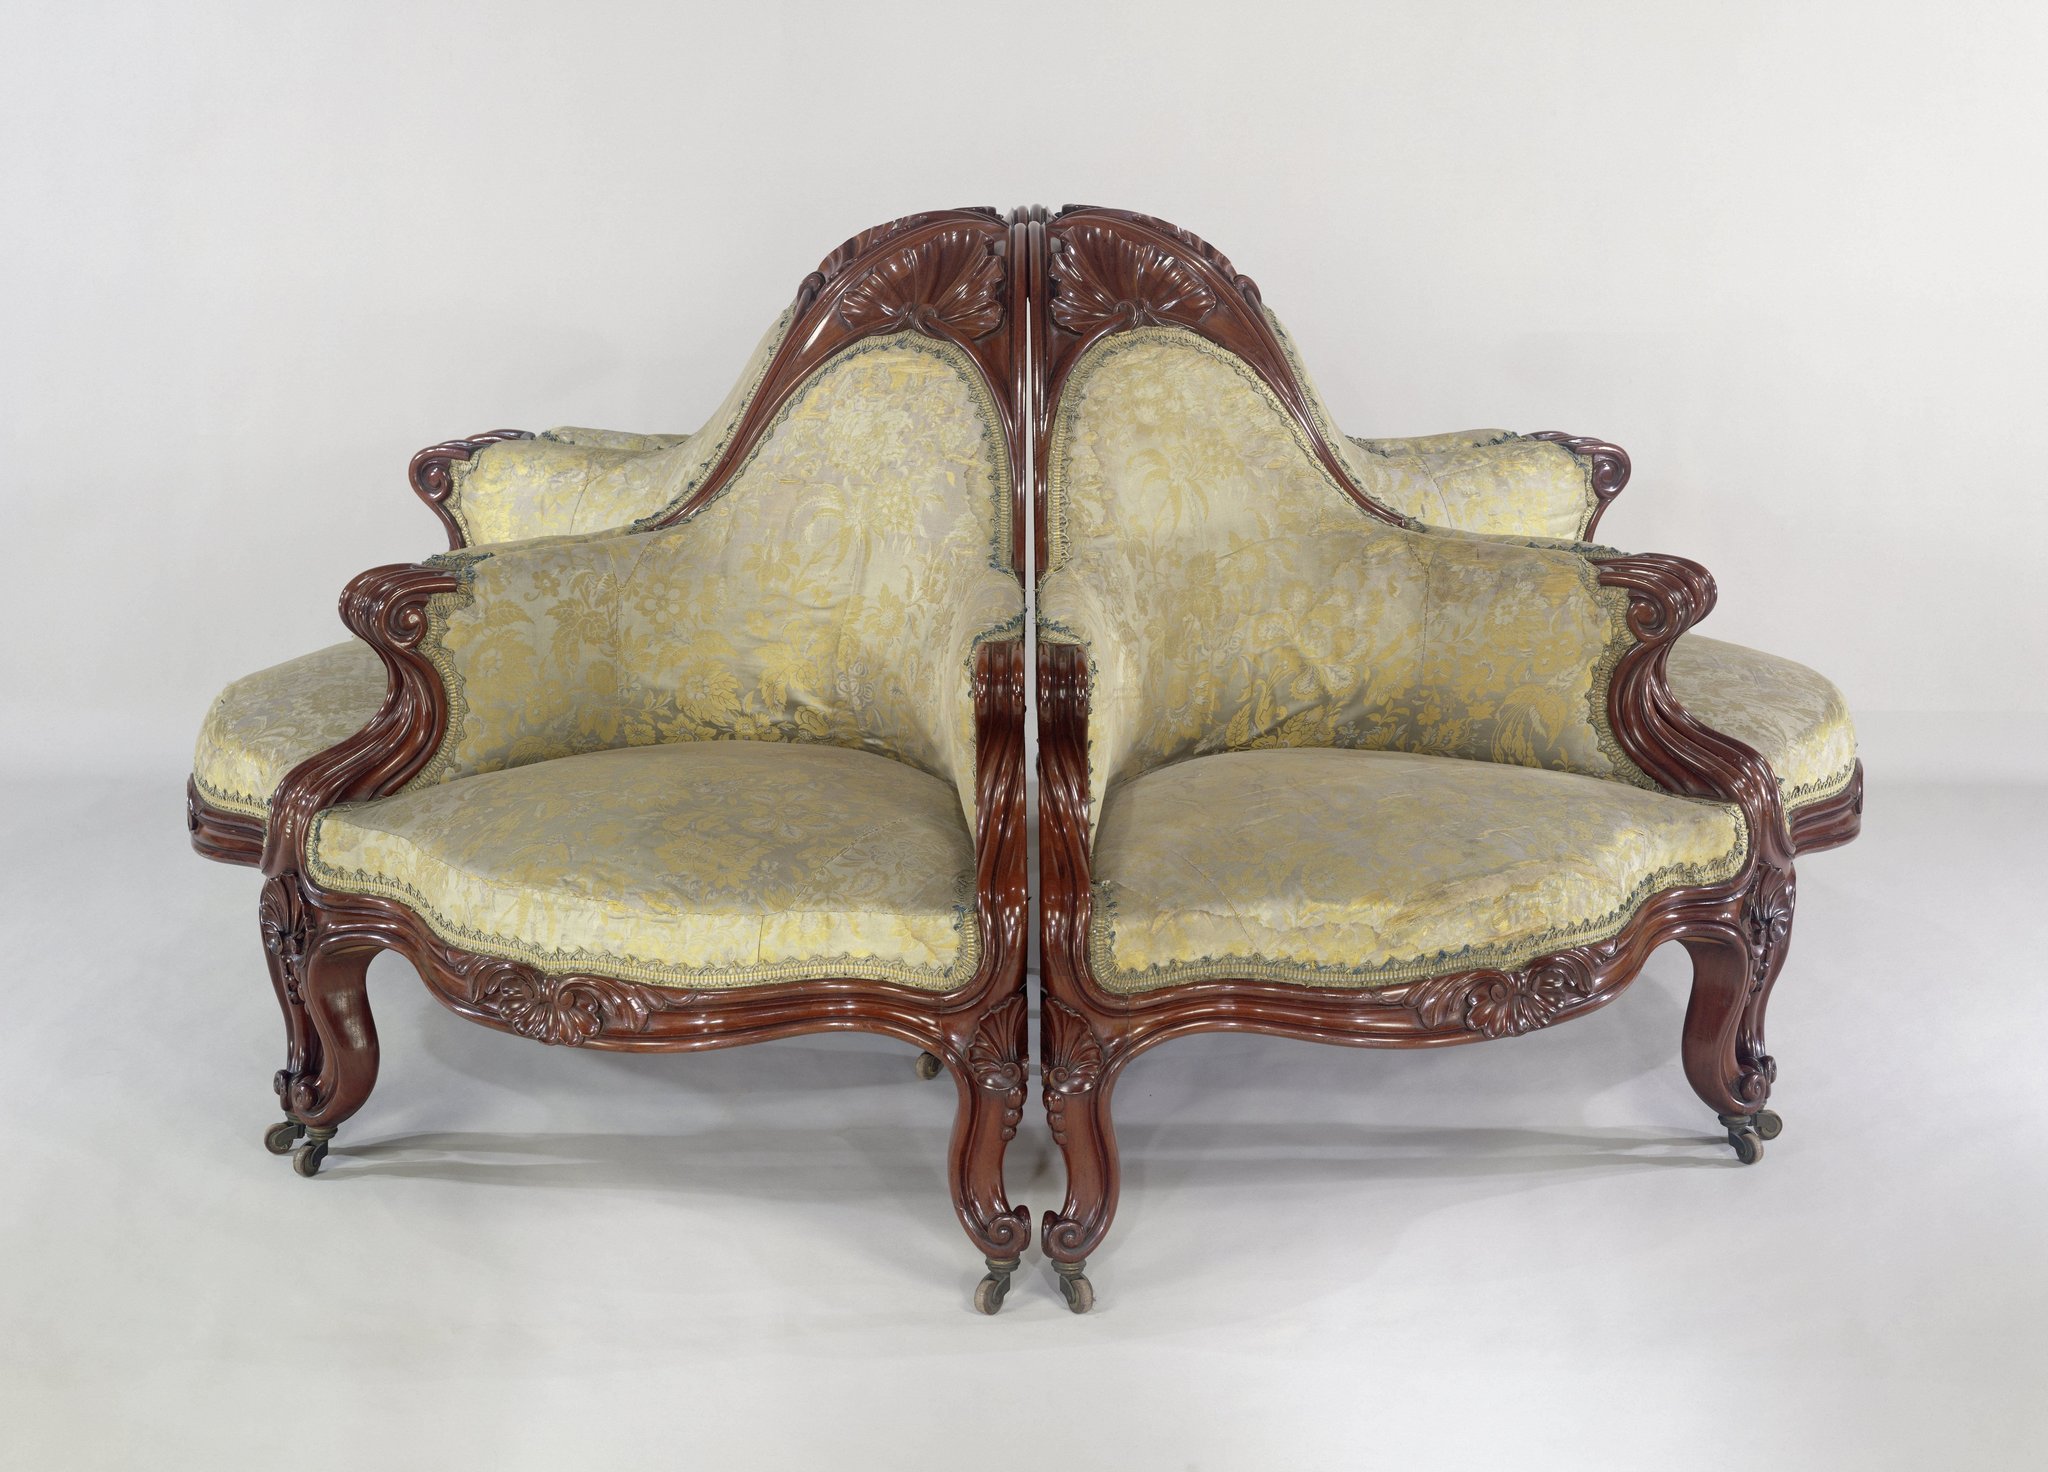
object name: chair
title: Armstoel, onderdeel van een divan de milieu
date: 1852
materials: wood, silk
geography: the hague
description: Divan de milieu. Mahogany, upholstered with silk lampas. The Hague, c. 1852, by the Horrix Brothers. The lampas France. The divan de milieu, which retains its original upholstery, was made for Prince Frederik of The Netherlands.